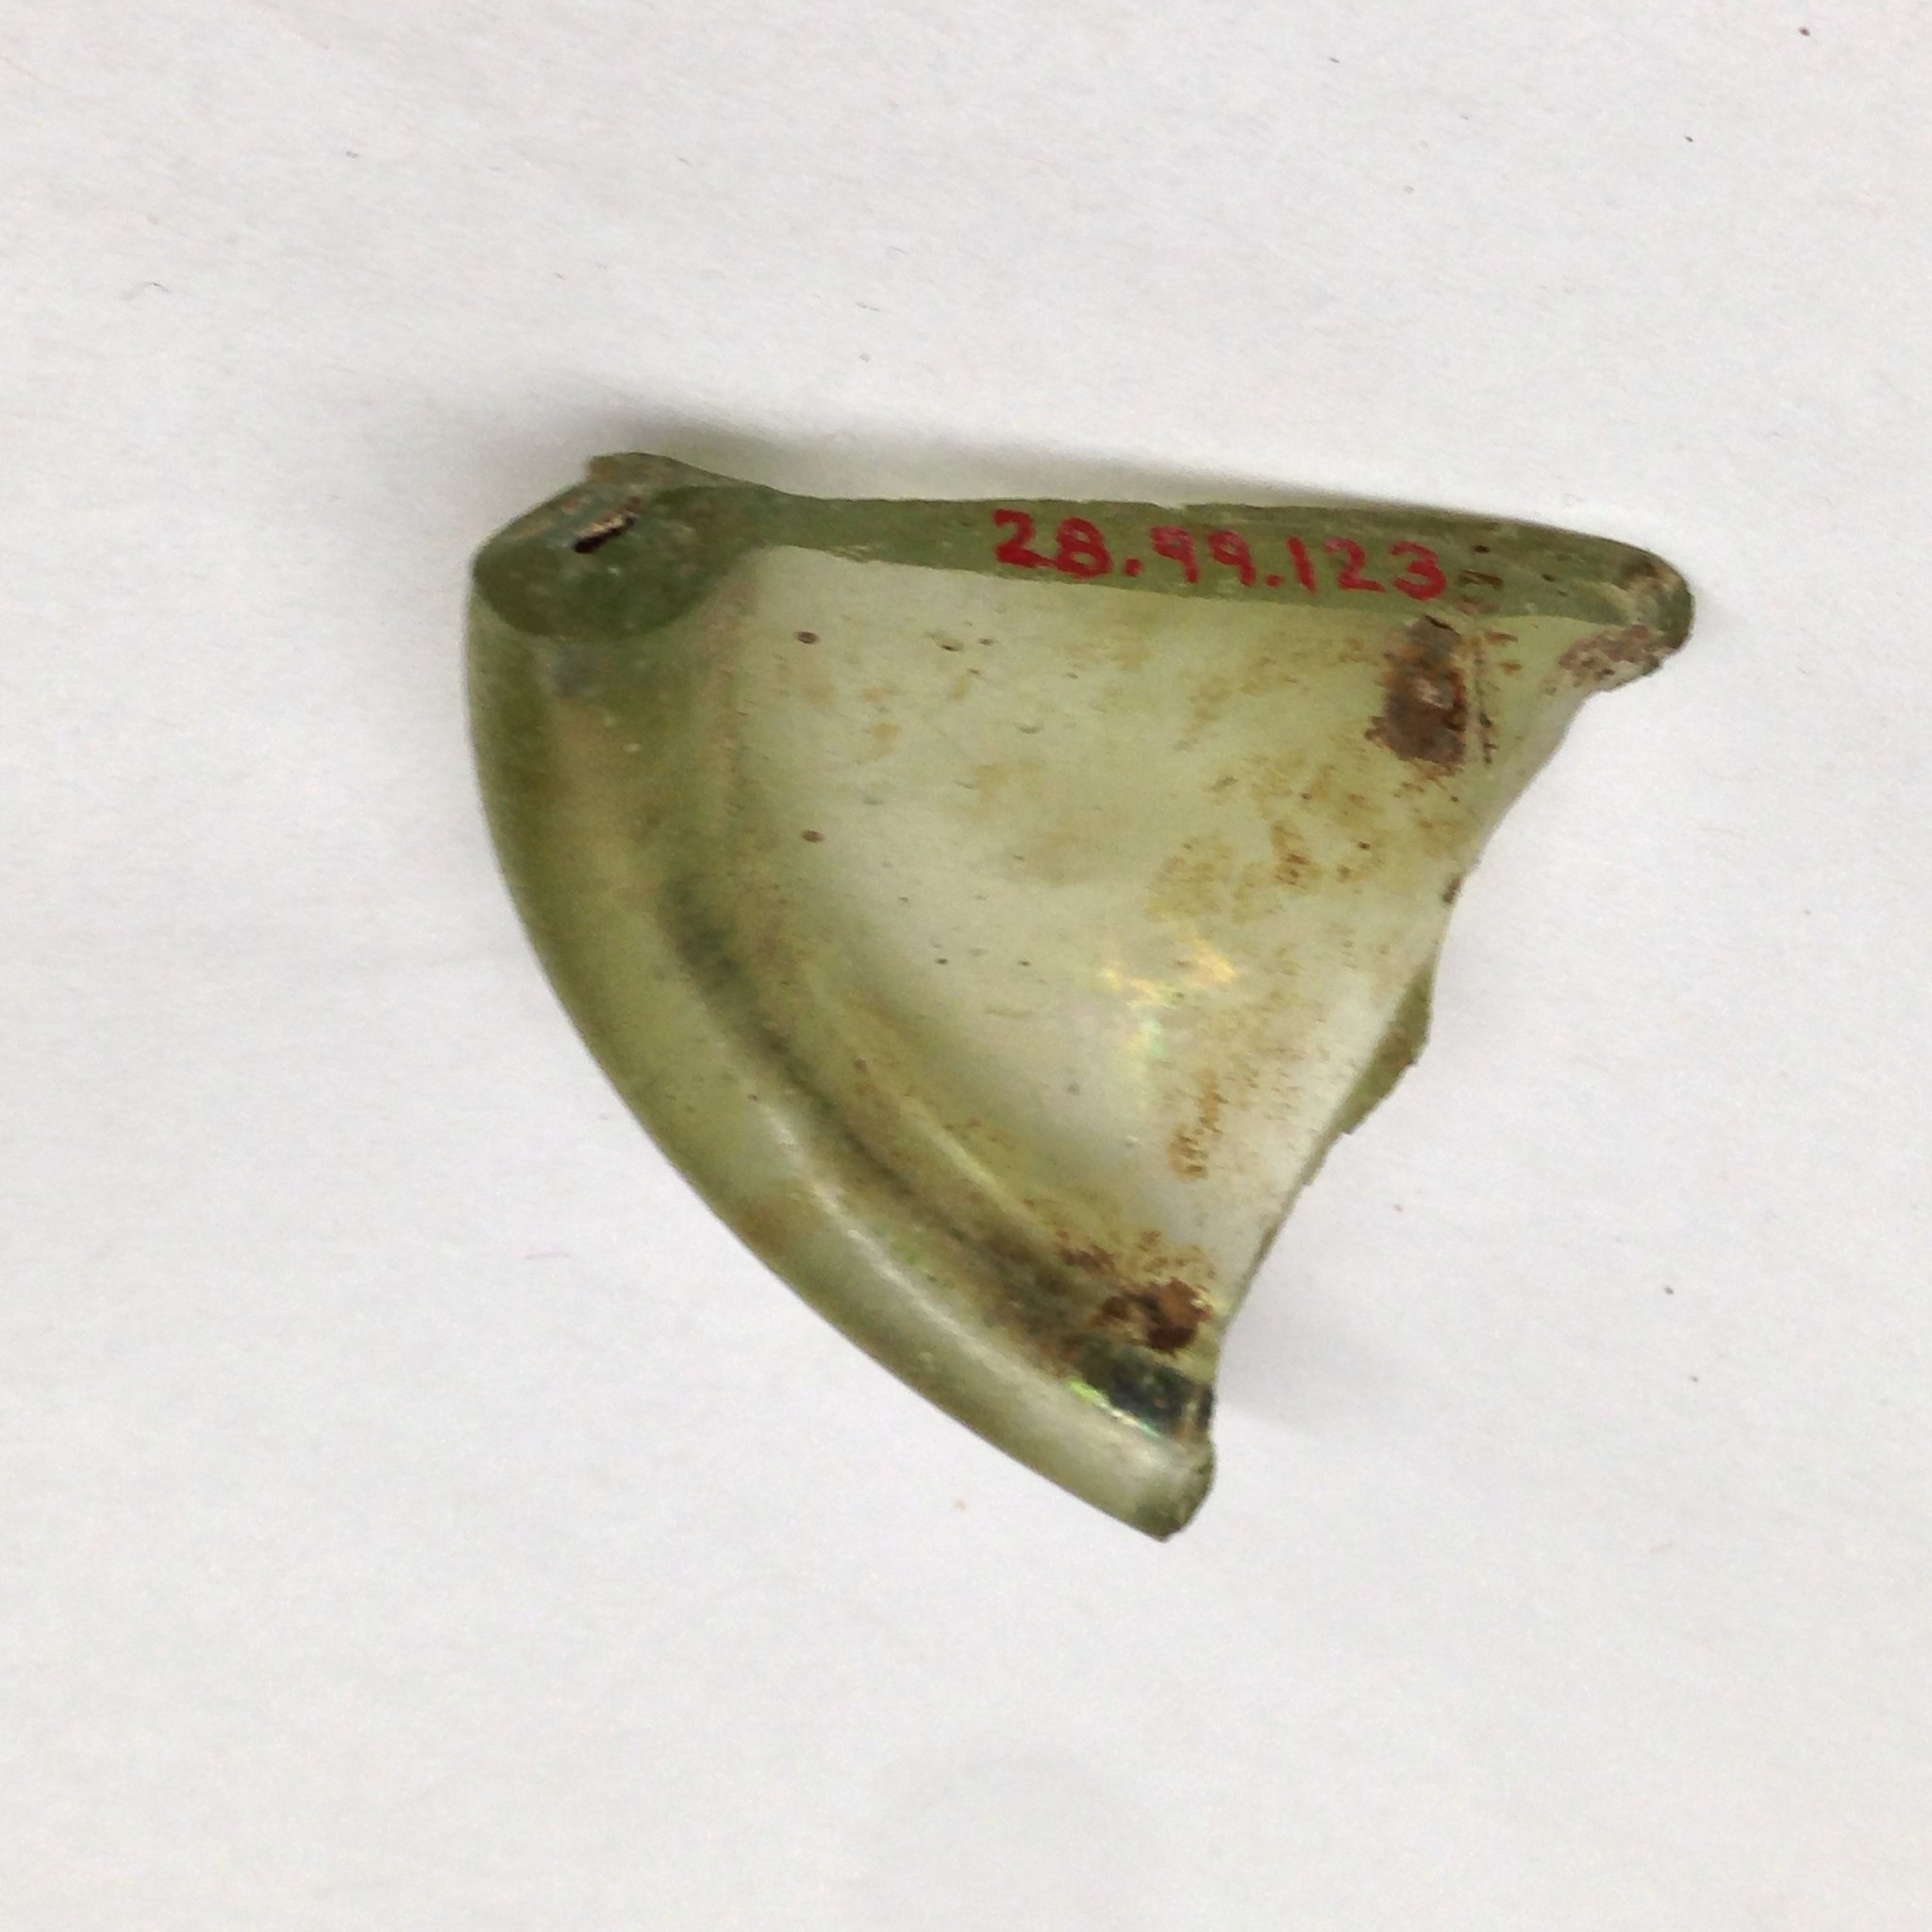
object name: fragment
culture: european or middle eastern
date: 1150-1250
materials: ceramic, glass